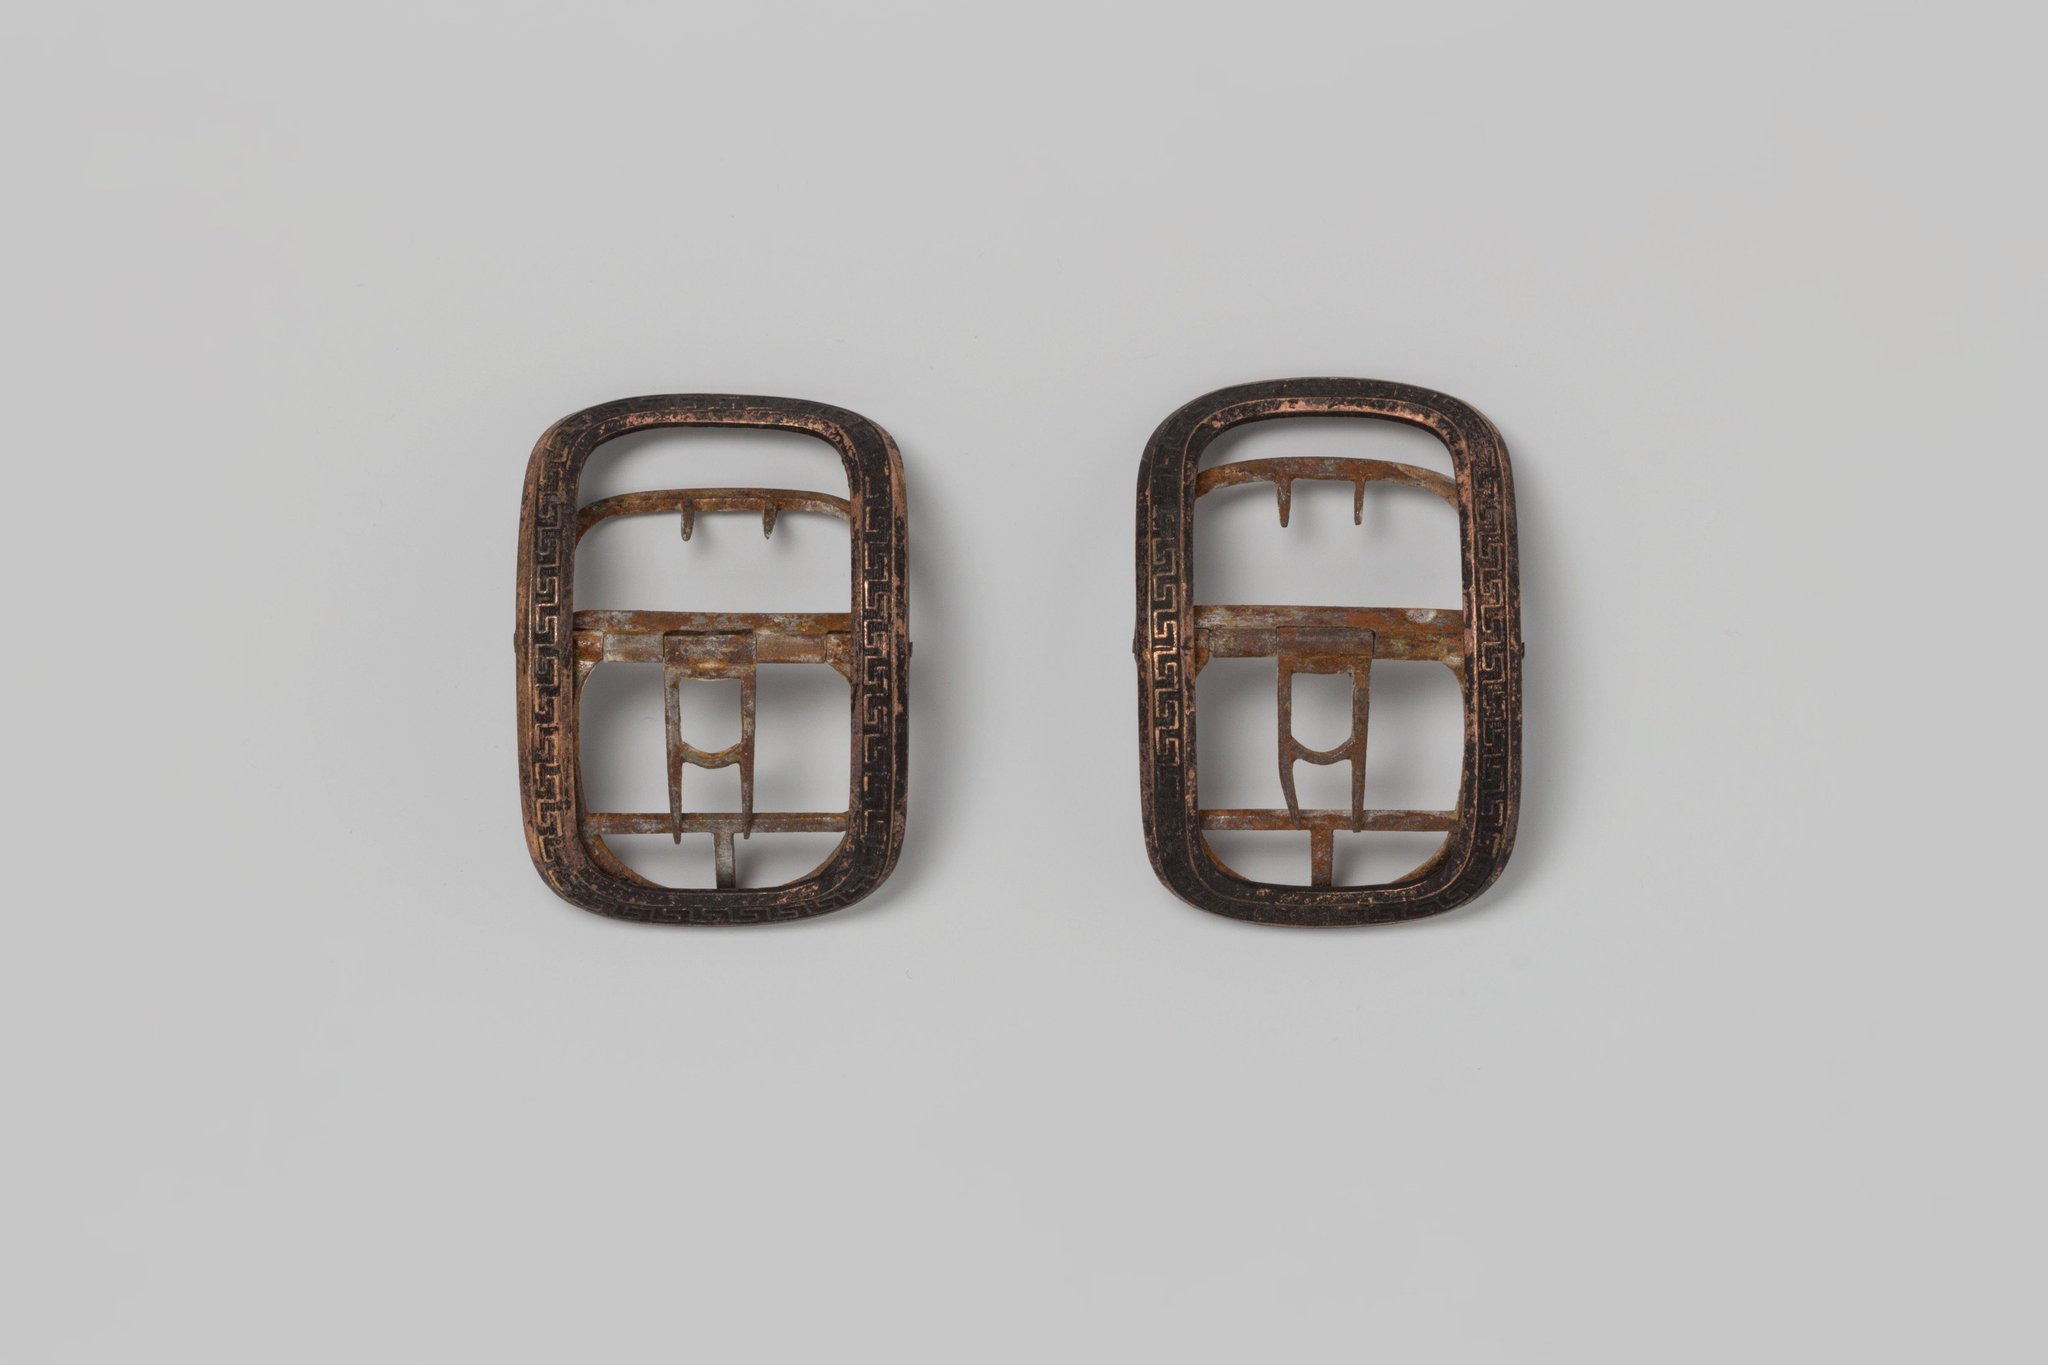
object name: clothing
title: Rechthoekige en gebogen schoengesp van verguld koper, versierd met een meander, in reliëf geciseleerd op een zwart fond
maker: Anonymous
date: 1800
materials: copper, metal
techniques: metalworking, gilding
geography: geneva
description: Schoengesp: Model: Rechthoekig met afgeronde hoeken en gebogen. Versiering: Tussen afgeschuinde gladde lijsten loopt een meander, en reliëf geciseleerd op een zwarte (?) fond. Ondergespen: Beide zijn gelijk en van staal met aan de spil twee boogvormige ogen, waarvan het ene twee scherpe punten heeft en het andere een kruisvormige steun voor de losse, scharnierende tong(?), die ook twee punten heeft. De spijl is in apart aangebrachte zijwangen van de bovengesp geklonken. Toestand: Het bovenblad is nagedonkerd, zodat niet in uit e maken of de grond als zwart bedoeld is of niet. De ondergesp geheel geroest. Eén der spillen zit los.